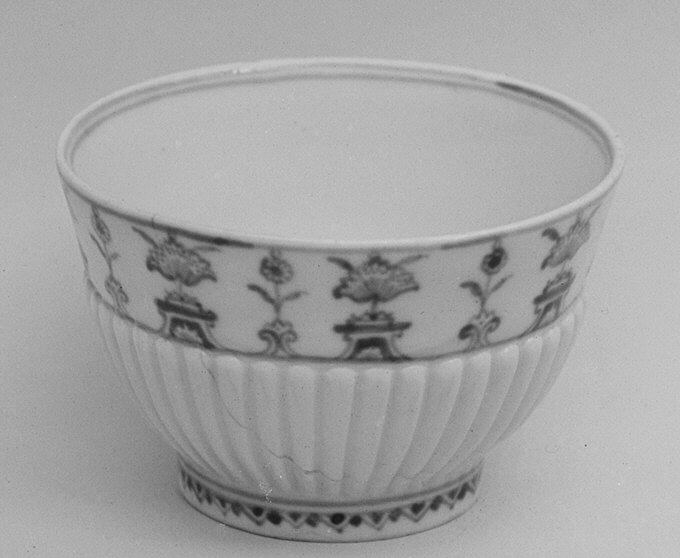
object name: teabowl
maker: saint-cloud factory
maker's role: factory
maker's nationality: french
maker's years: 1693-1766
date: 1715-1730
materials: soft paste porcelain